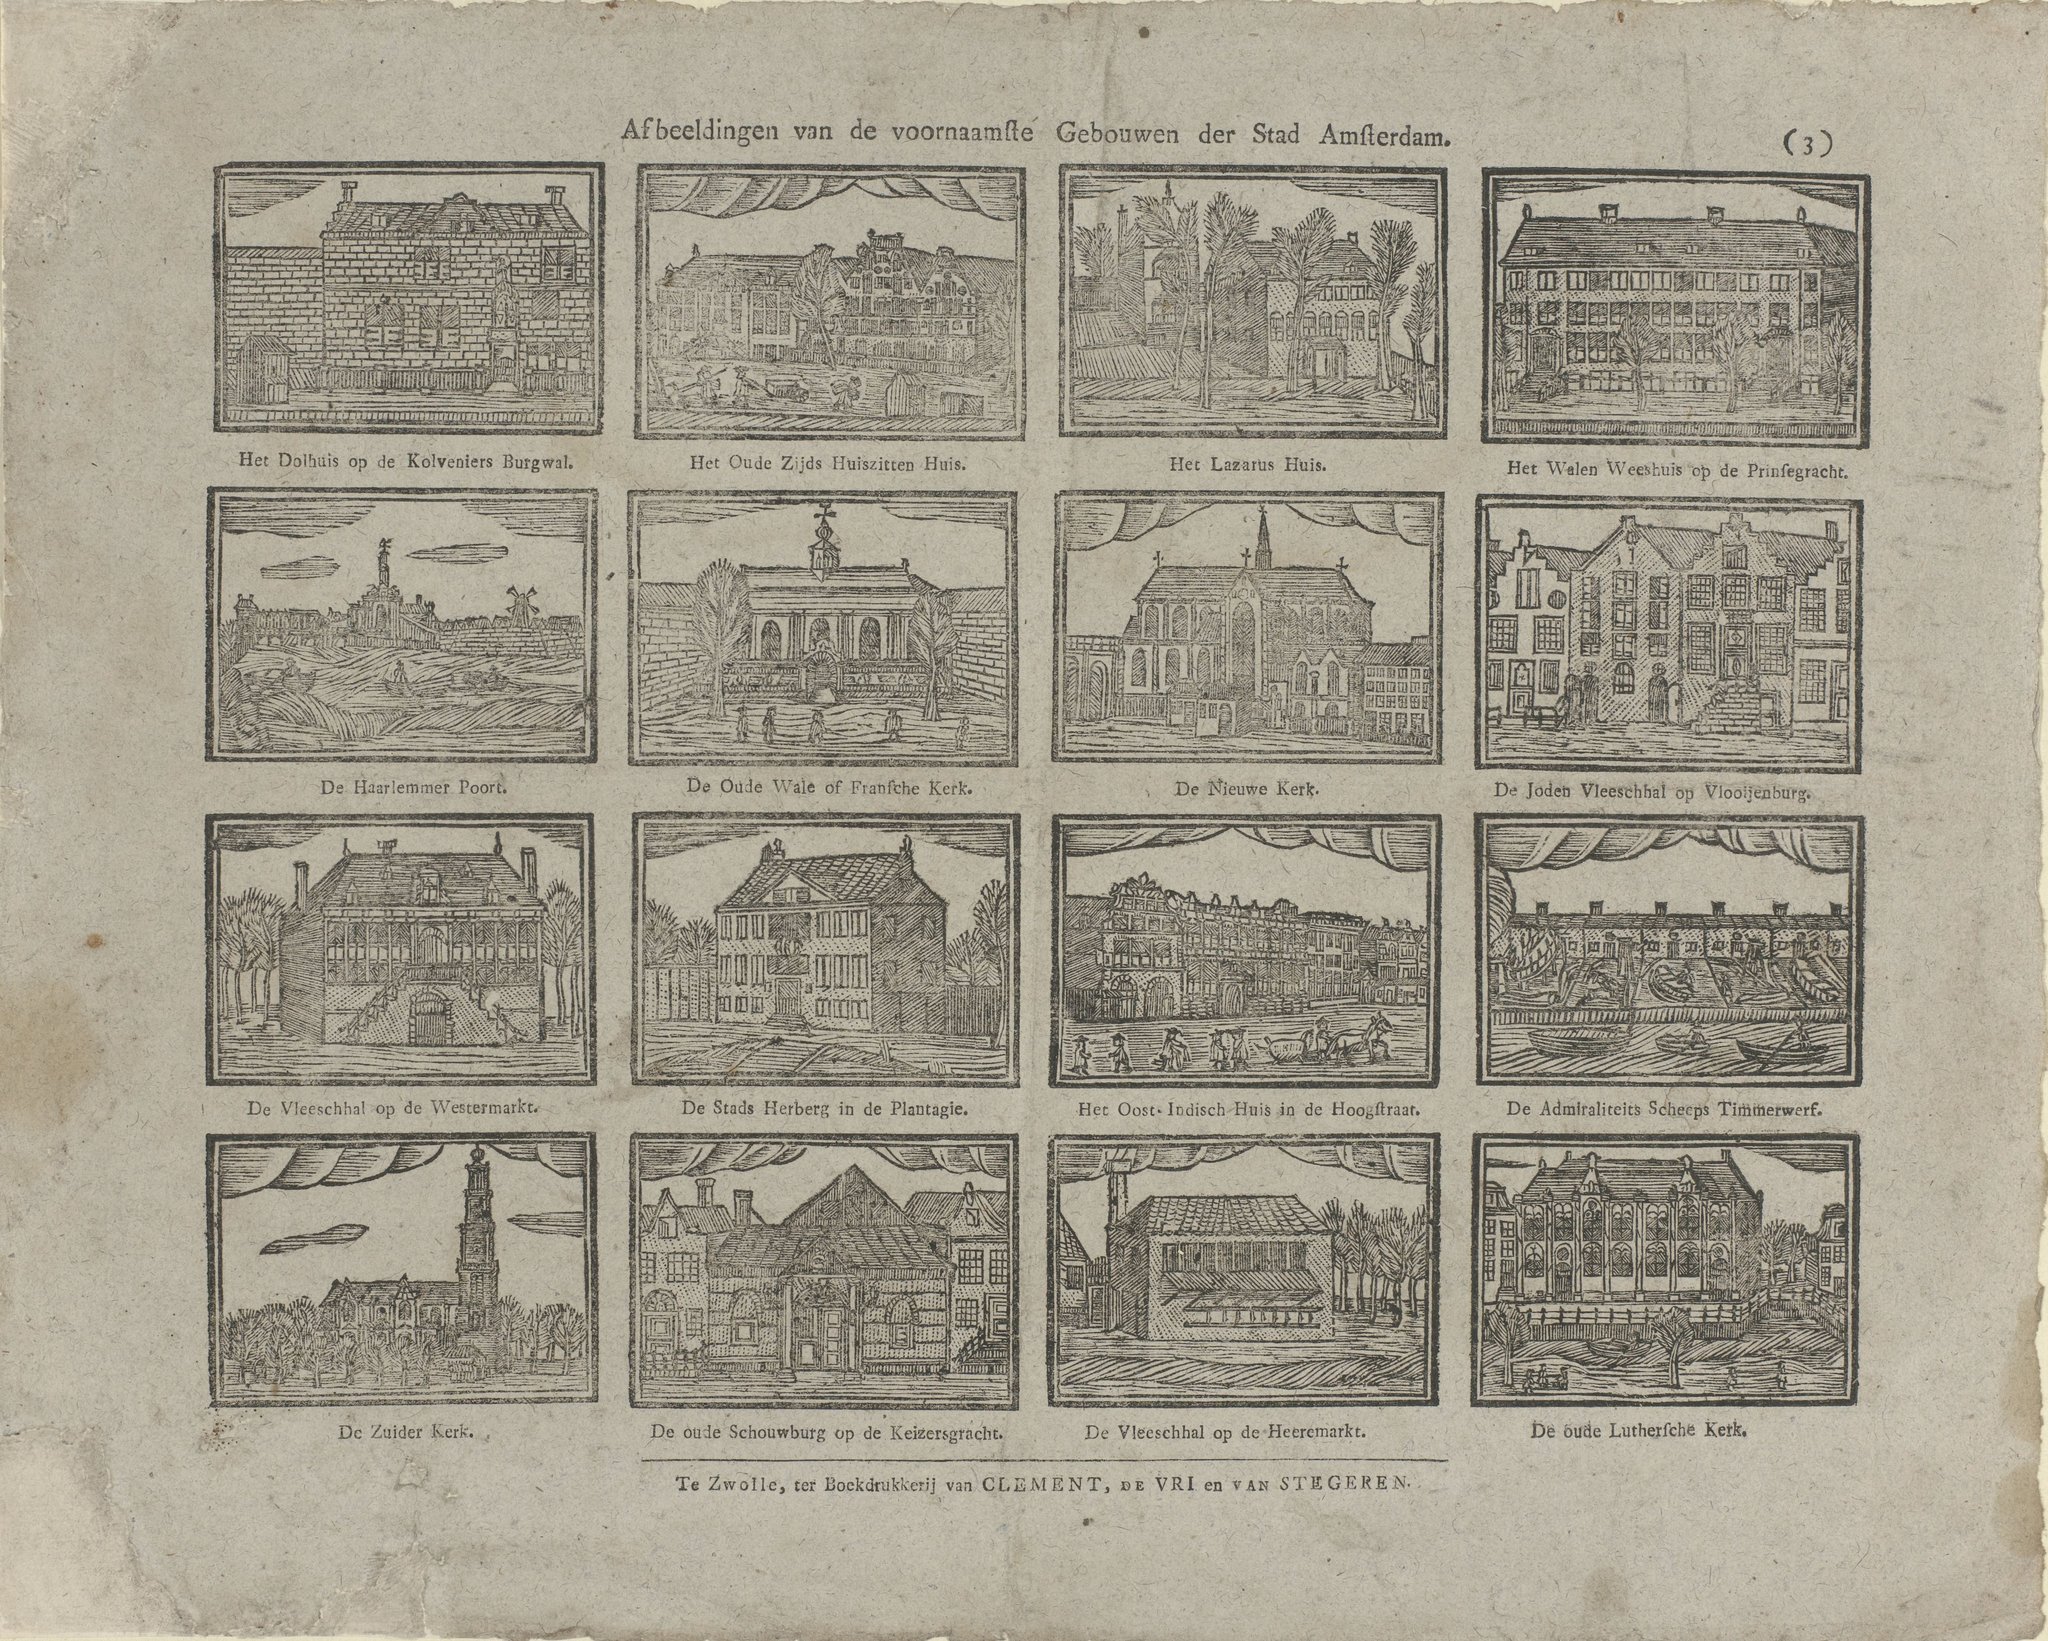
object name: print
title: Afbeeldingen van de voornaamste gebouwen der stad Amsterdam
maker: Anonymous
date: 1816-1836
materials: paper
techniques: letterpress printing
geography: zwolle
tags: theatre (building), roman catholic church, city-gate, market-hall, dolhuis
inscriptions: collector's mark: Lugt 2760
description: Blad met 16 voorstellingen van bekende gebouwen in Amsterdam, zoals het Dolhuis, het Walen Weeshuis, de Nieuwe Kerk en de Haarlemmer Poort. Onder elke voorstelling de naam van het gebouw. Genummer rechtsboven: (3).